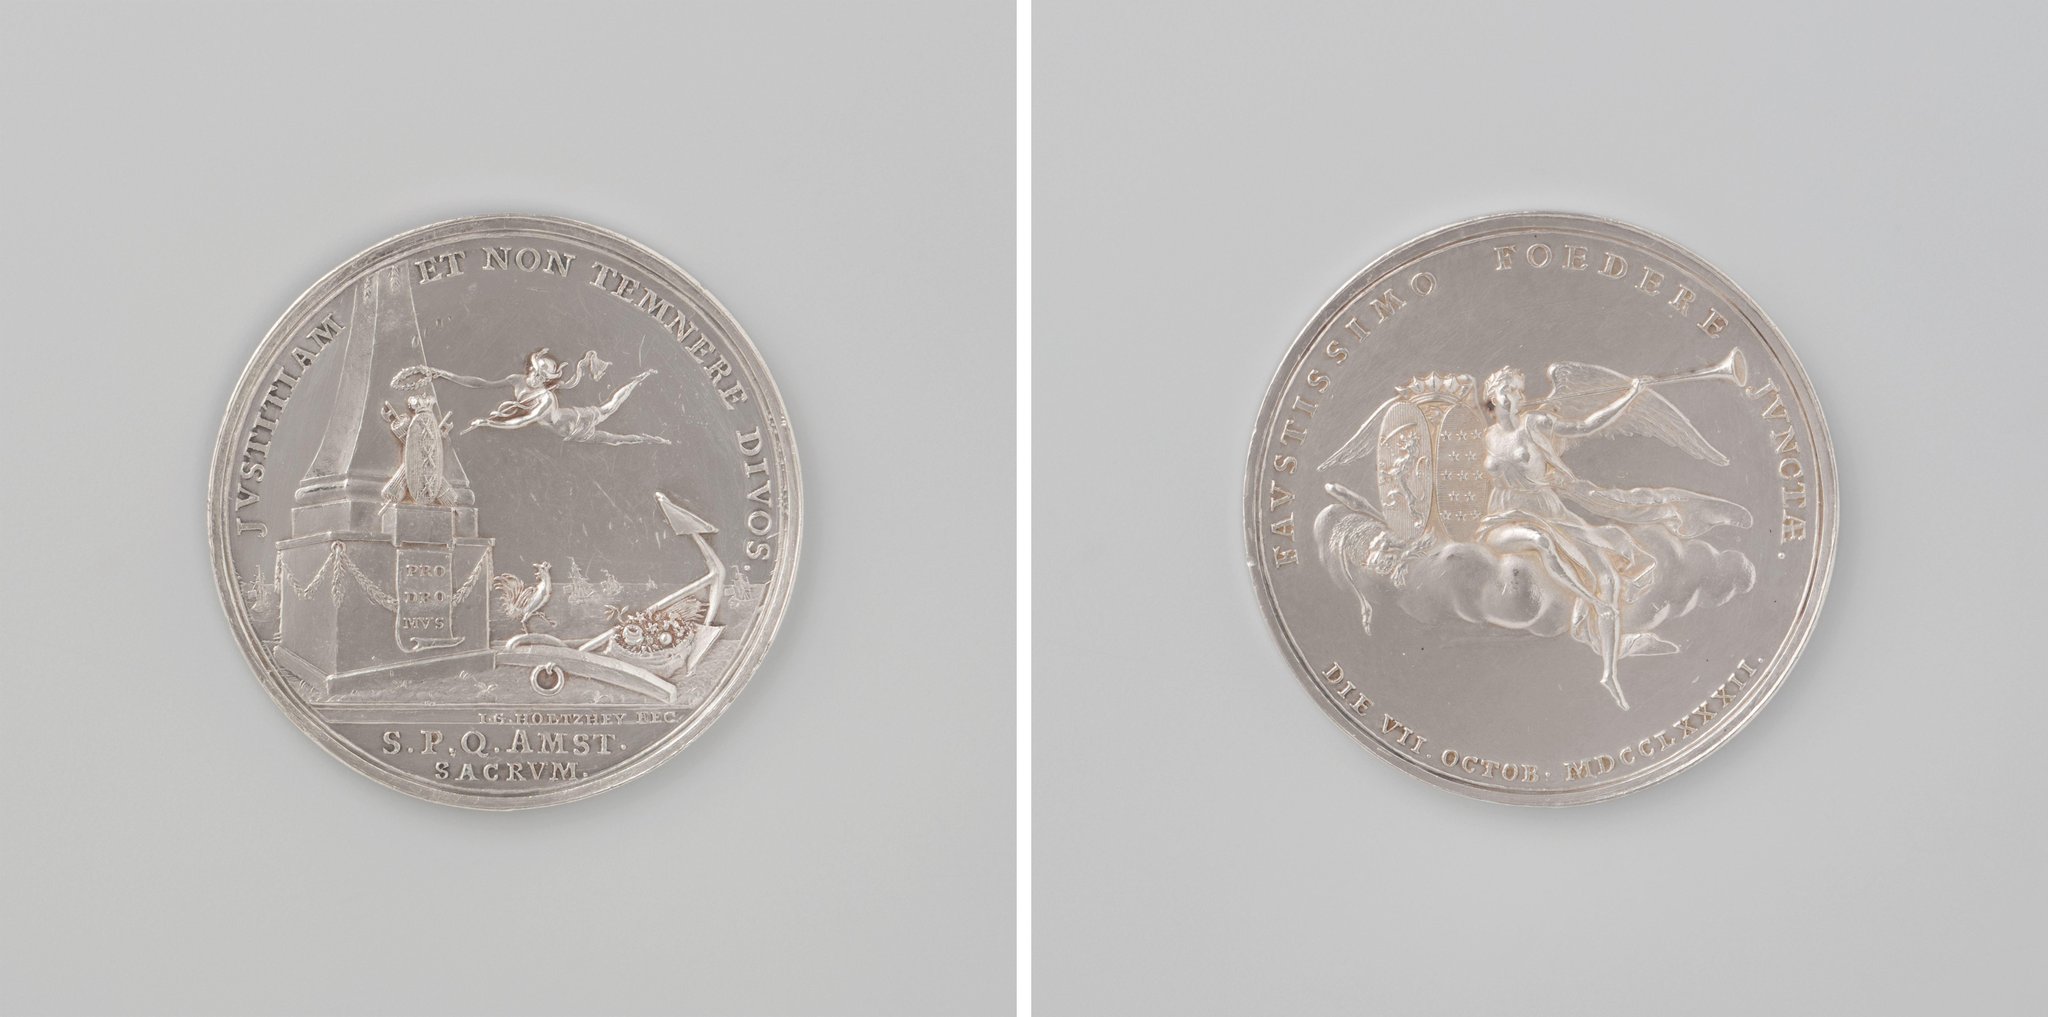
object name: history medal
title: Sluiting van het Commercietractaat tussen de Verenigde Staten van Amerika en de Staten-Generaal der Verenigde Nederlanden te 's-Gravenhage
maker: johan george holtzhey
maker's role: mintmaster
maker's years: 1726-1808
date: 1782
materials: silver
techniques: striking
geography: amsterdam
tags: united states of america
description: Medal, after a design by I. van Baerl, struck in 1782 to mark the treaty of trade and friendship between the Republic and the United States.